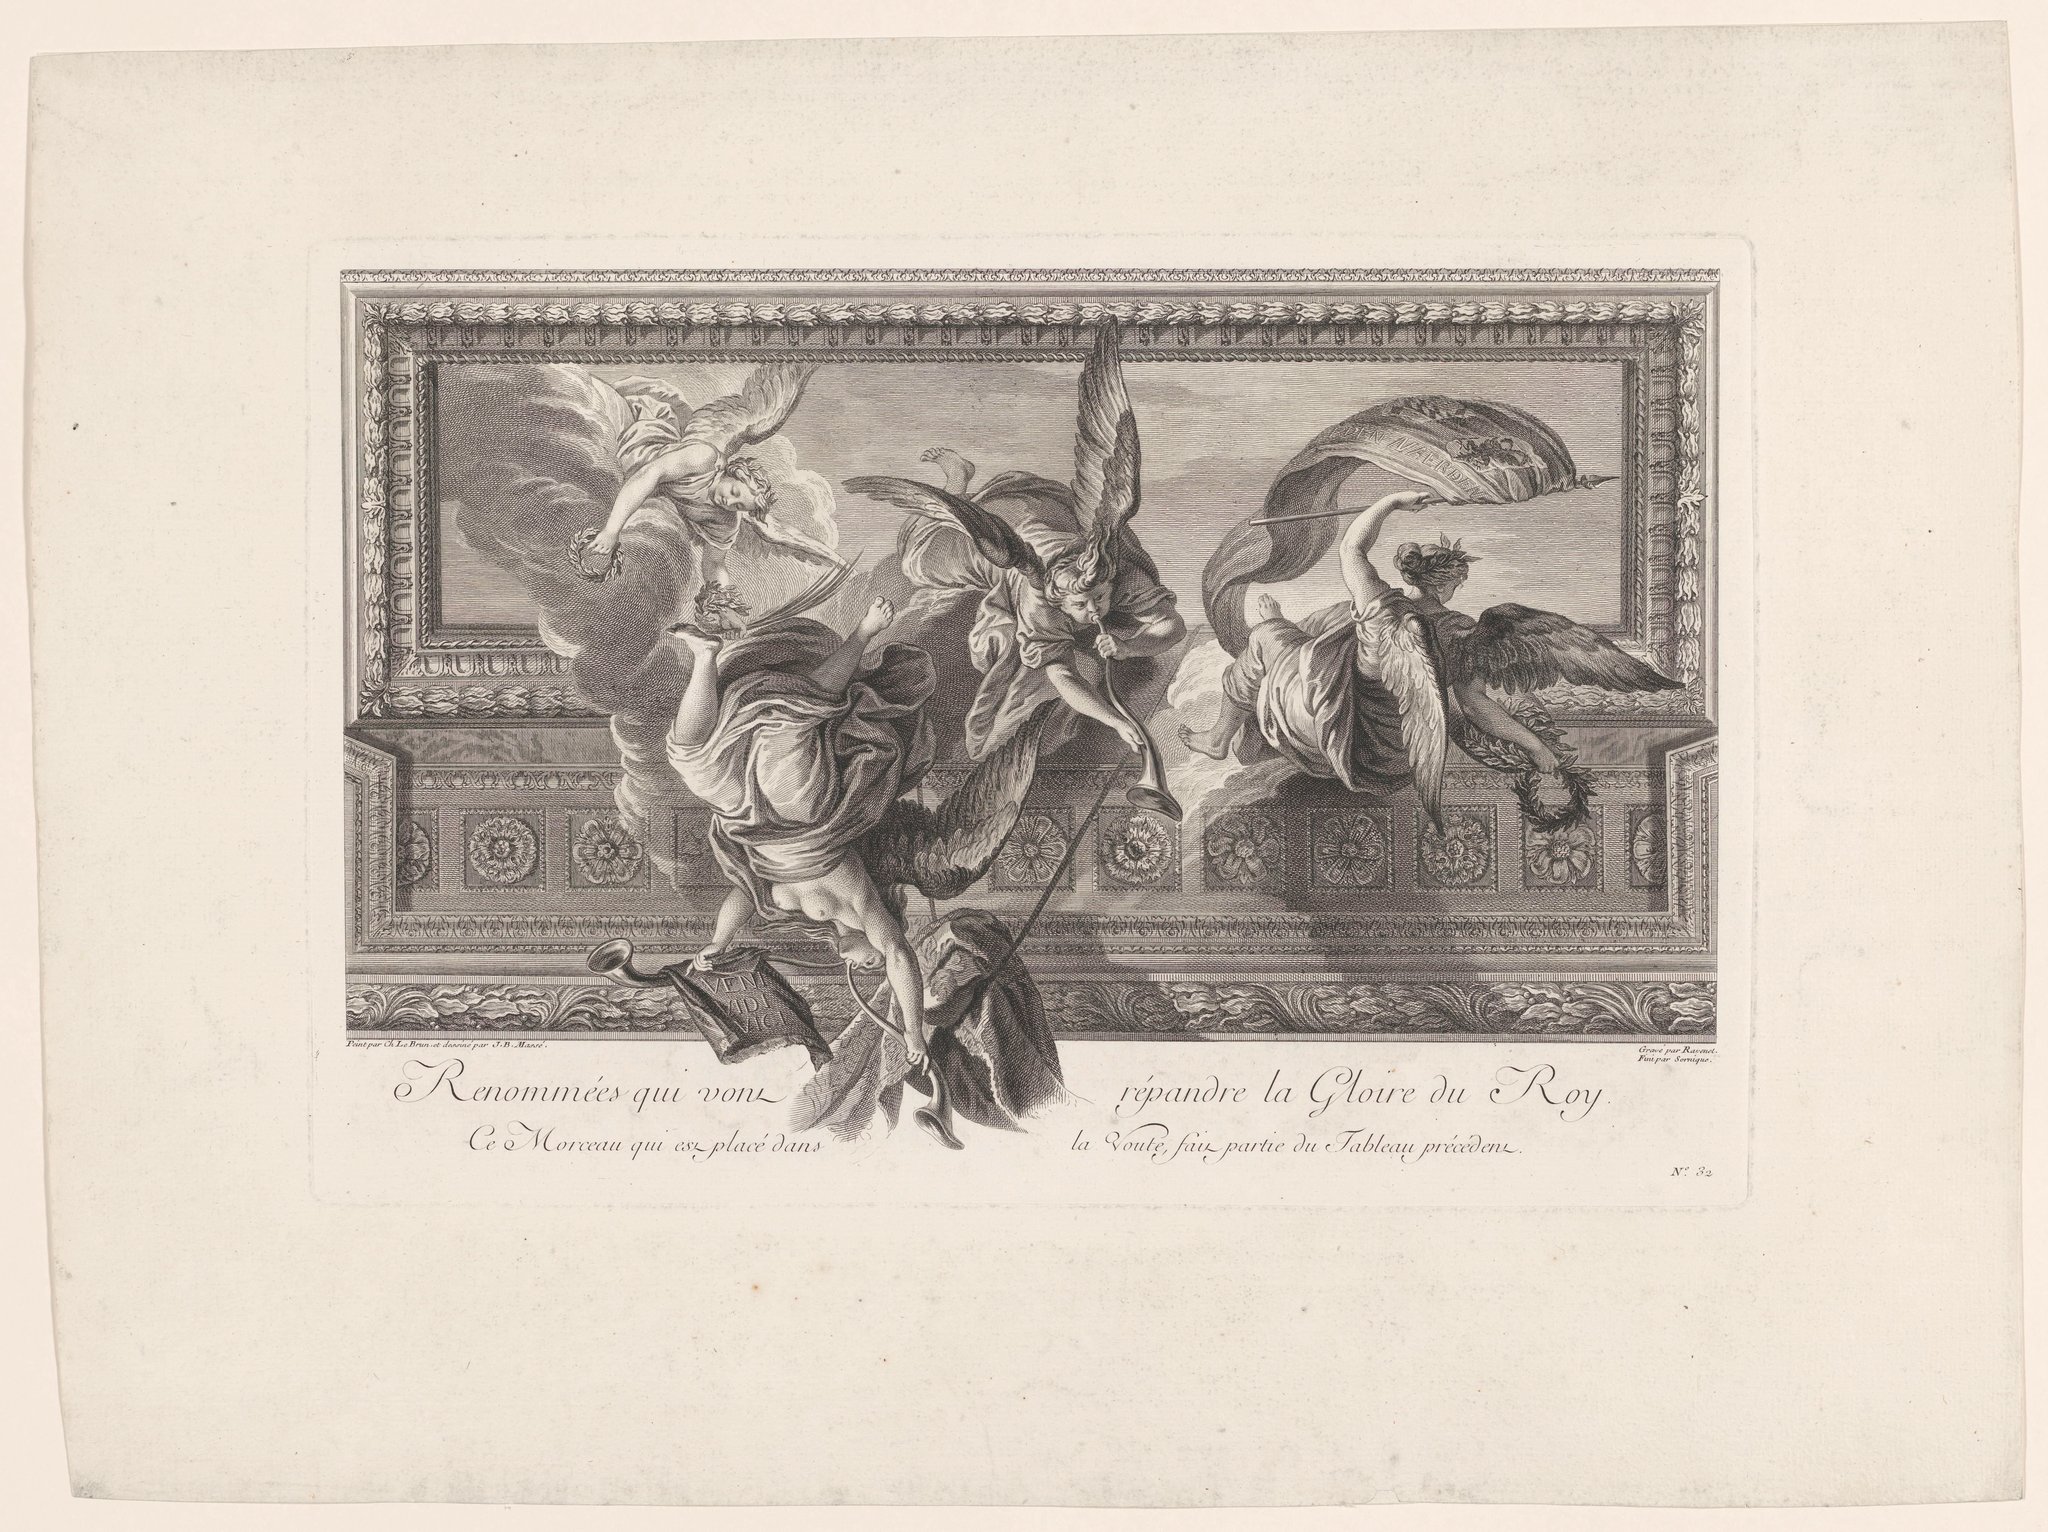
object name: print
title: Engelen verkondigen de faam van Lodewijk XIV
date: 1752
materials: paper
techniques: engraving, etching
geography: france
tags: lodewijk xiv (koning van frankrijk), angels singing, making music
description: Prent uit: Massé, Jean Baptiste. La Grande Galerie de Versailles, et les deux salons qui l'accompagnent, peints par Charles le Brun premier peintre de Louis XIV, dessinés par Jean- Baptiste Masse peintre et conseiller de l'Academie royale de peinture & sculpture; et gravés sous ses yeux par les meilleurs maitres du tems. Parijs: Imprimerie Royale, 1752.